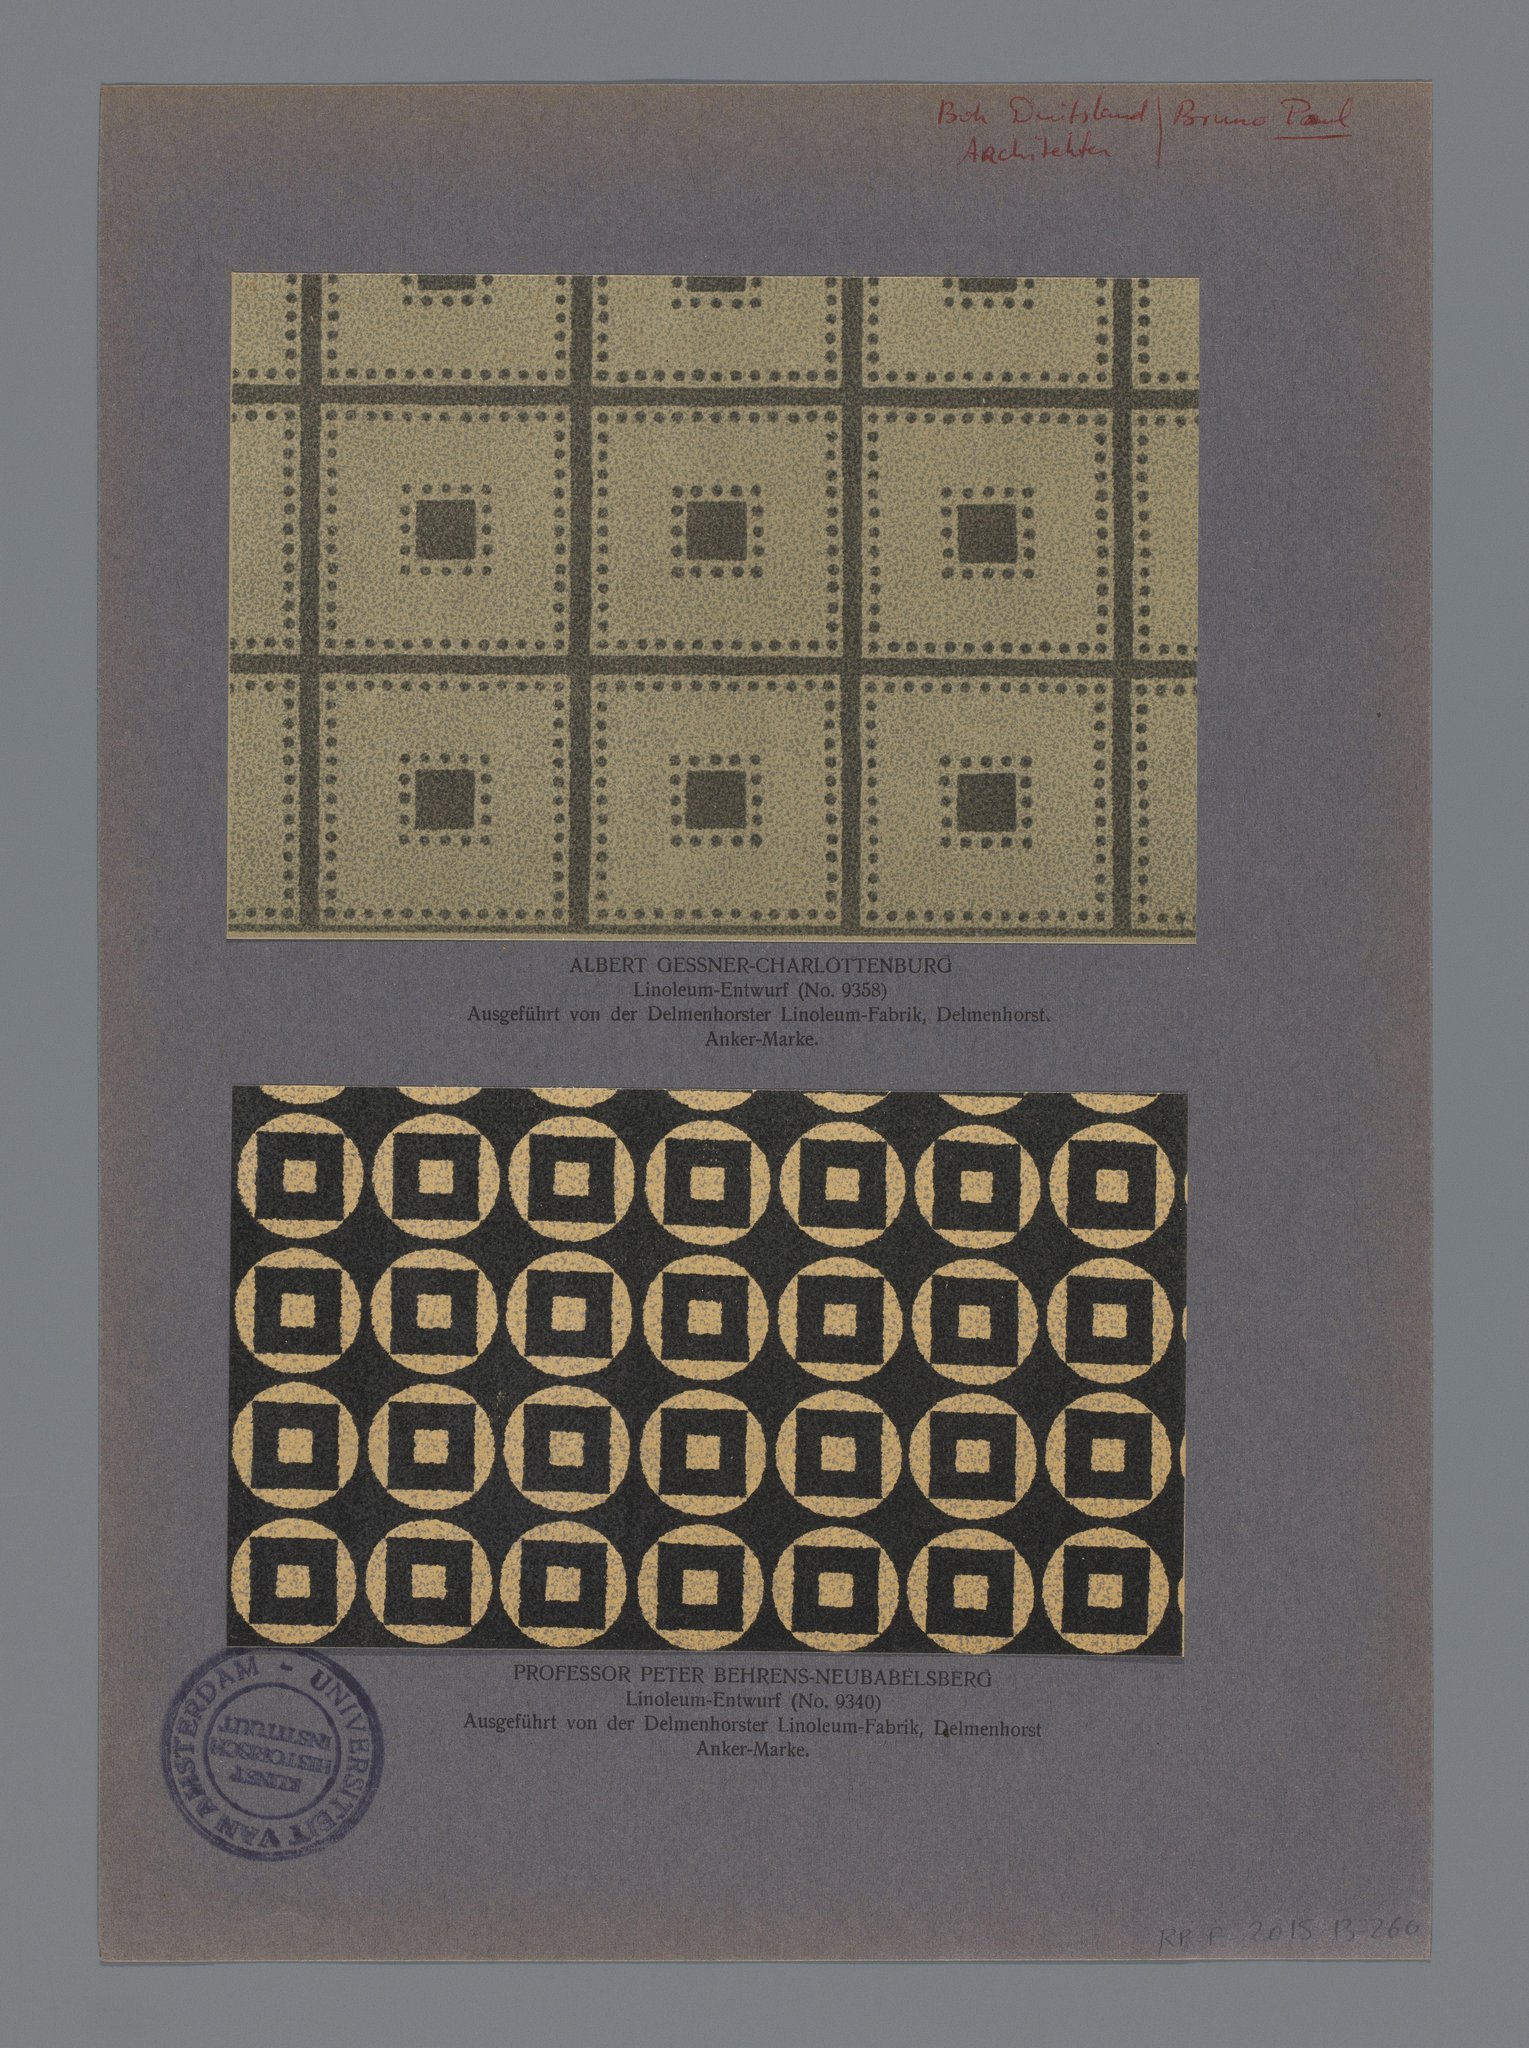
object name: photograph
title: Linoleo. Professor Bruno Paul-Berlin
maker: Anonymous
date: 1900-1950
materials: photographic process, photographic support